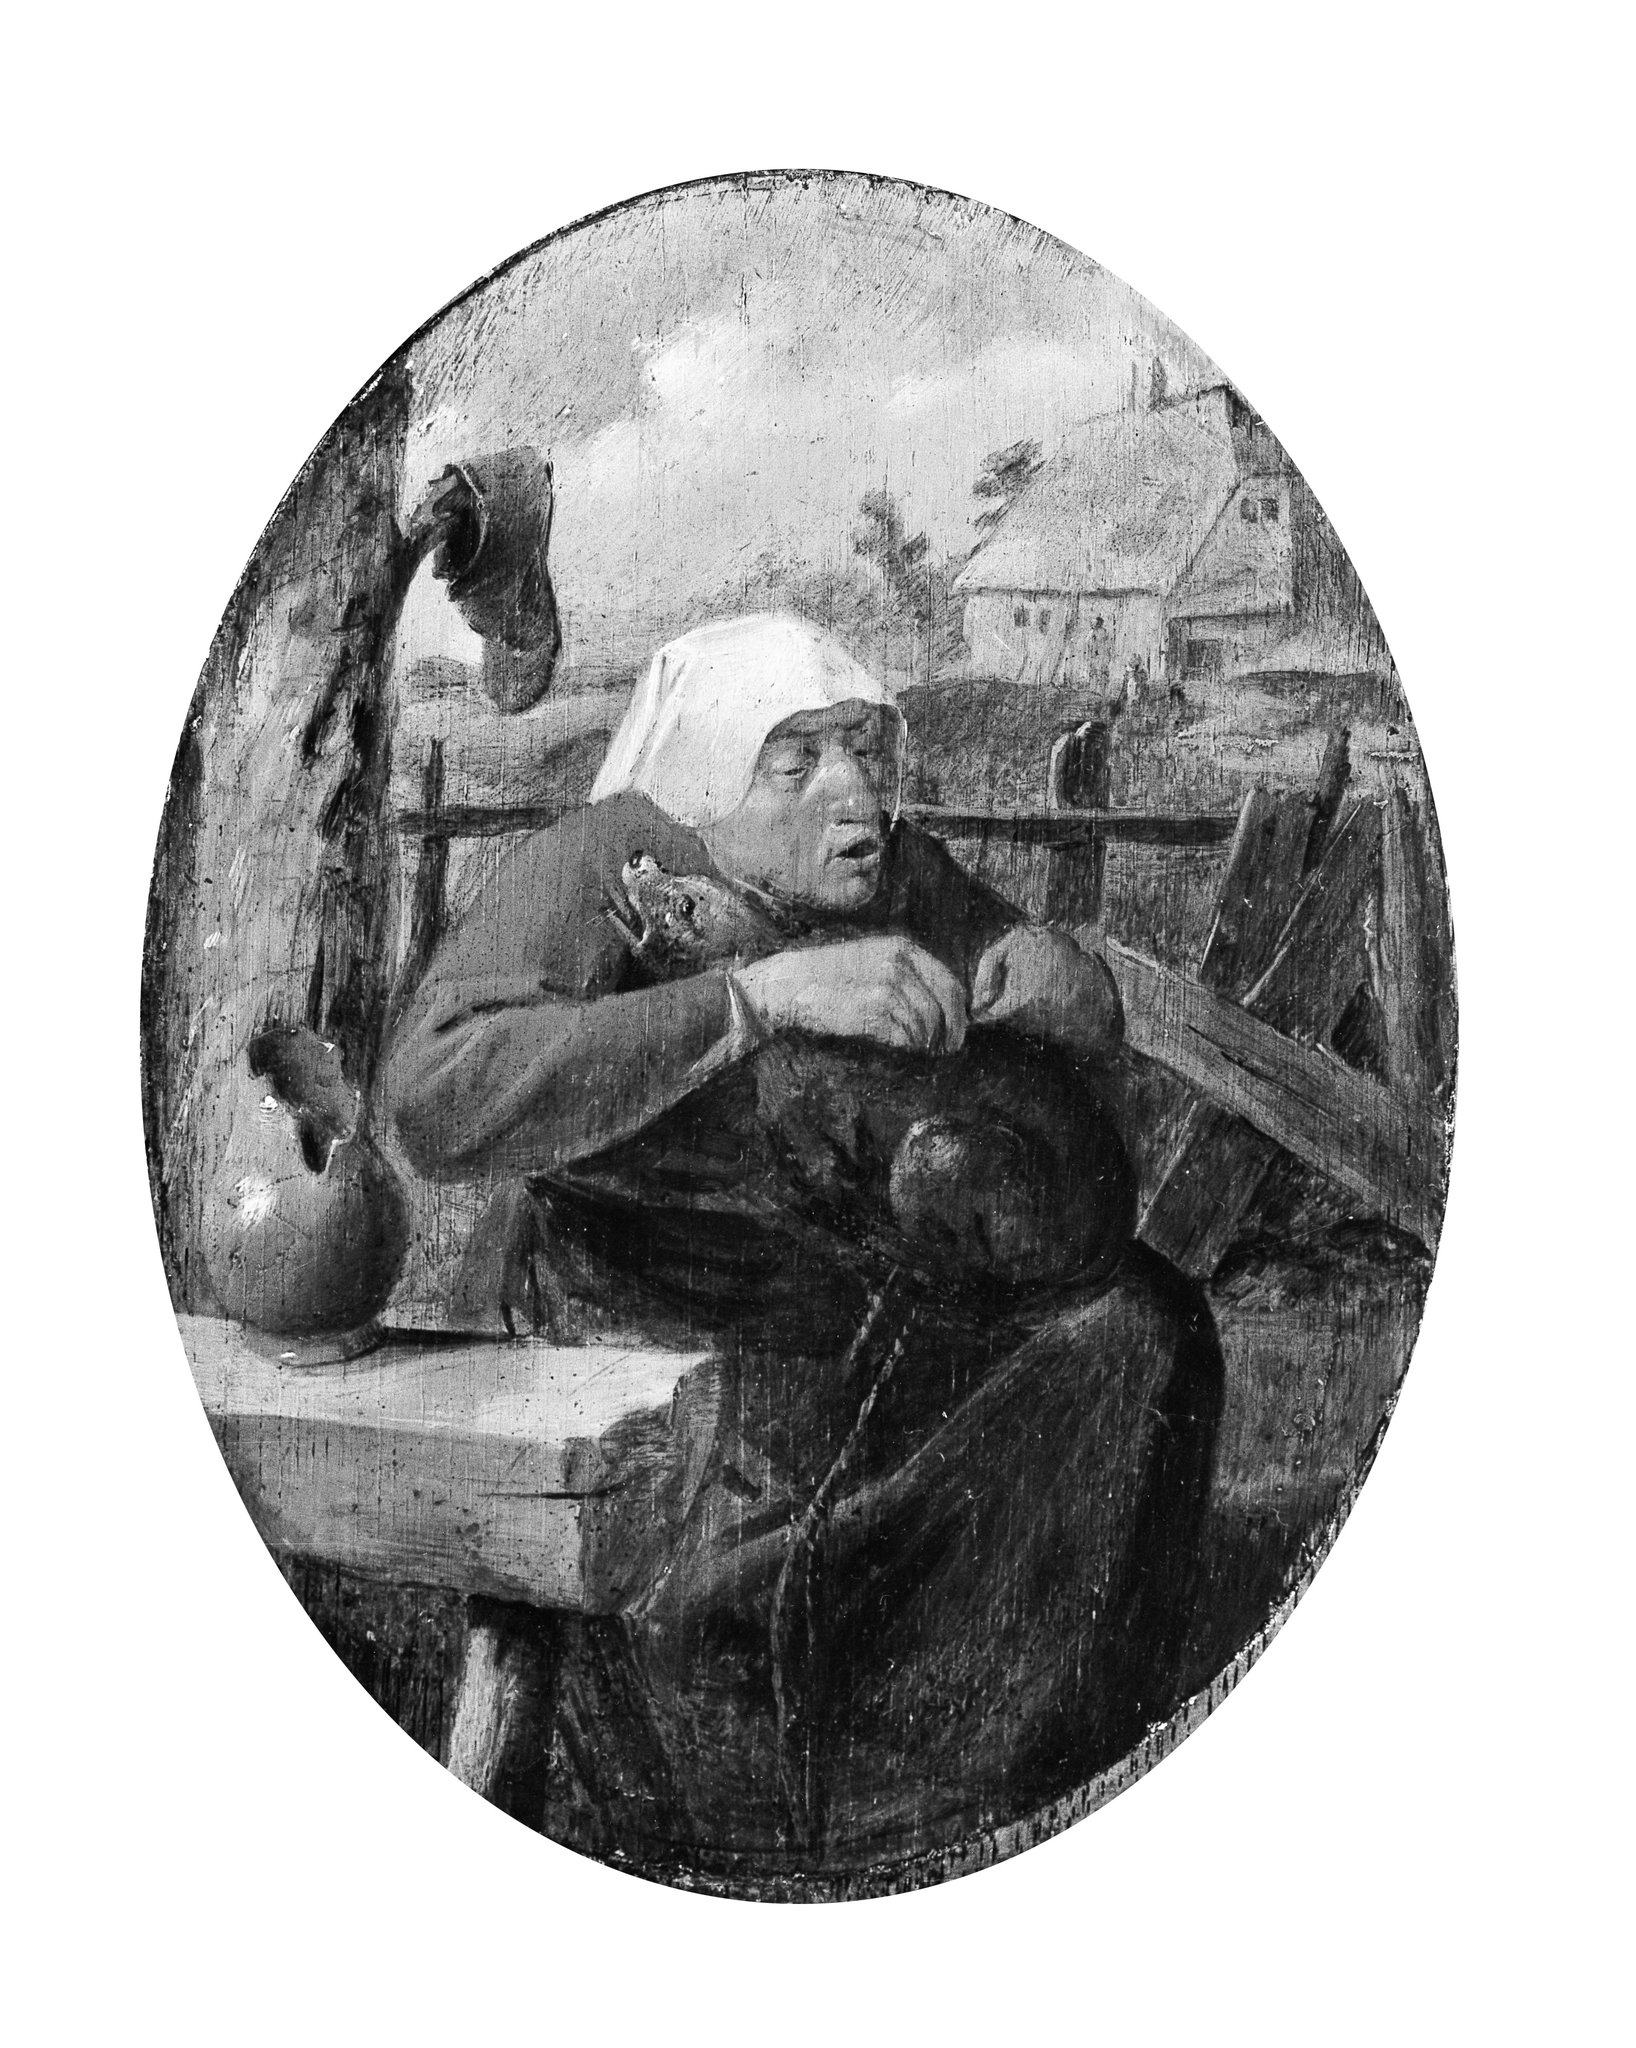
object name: painting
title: A Peasant Woman Picking Fleas off a Dog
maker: adriaen brouwer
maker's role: artist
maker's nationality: flemish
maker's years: 1605-1638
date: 1626-1627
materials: oil, wood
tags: women,dogs